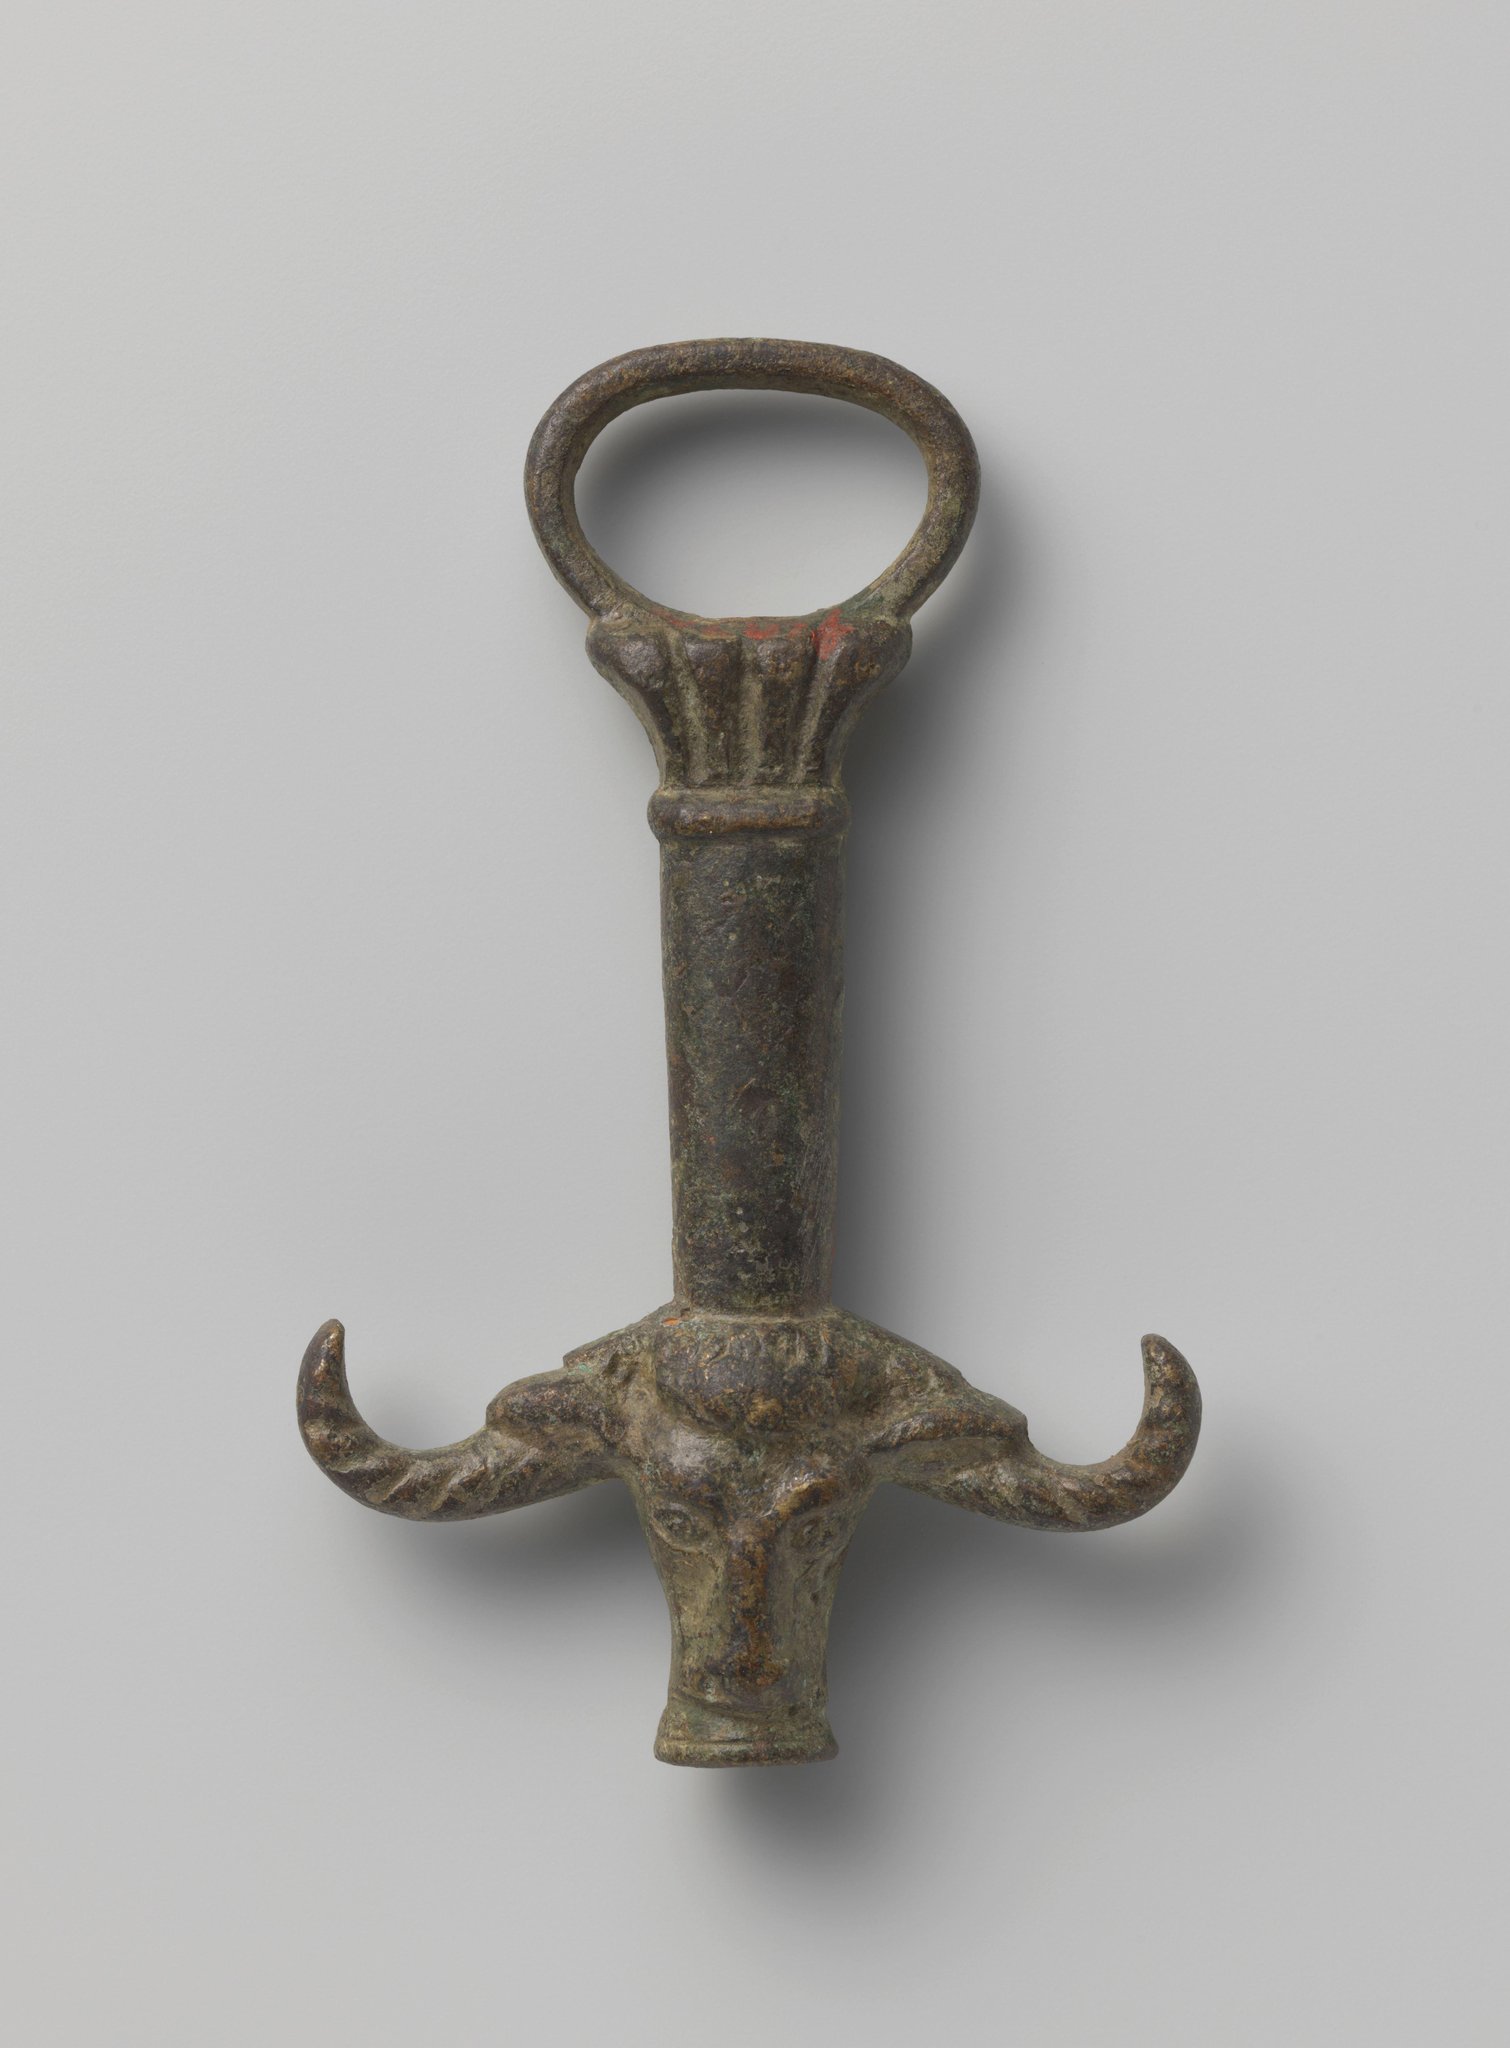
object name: tengelring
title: Bronzen tengelring in de vorm van een ramskop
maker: Anonymous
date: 1400-1950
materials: bronze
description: Bronzen tengelring in de vorm van een ramskop.